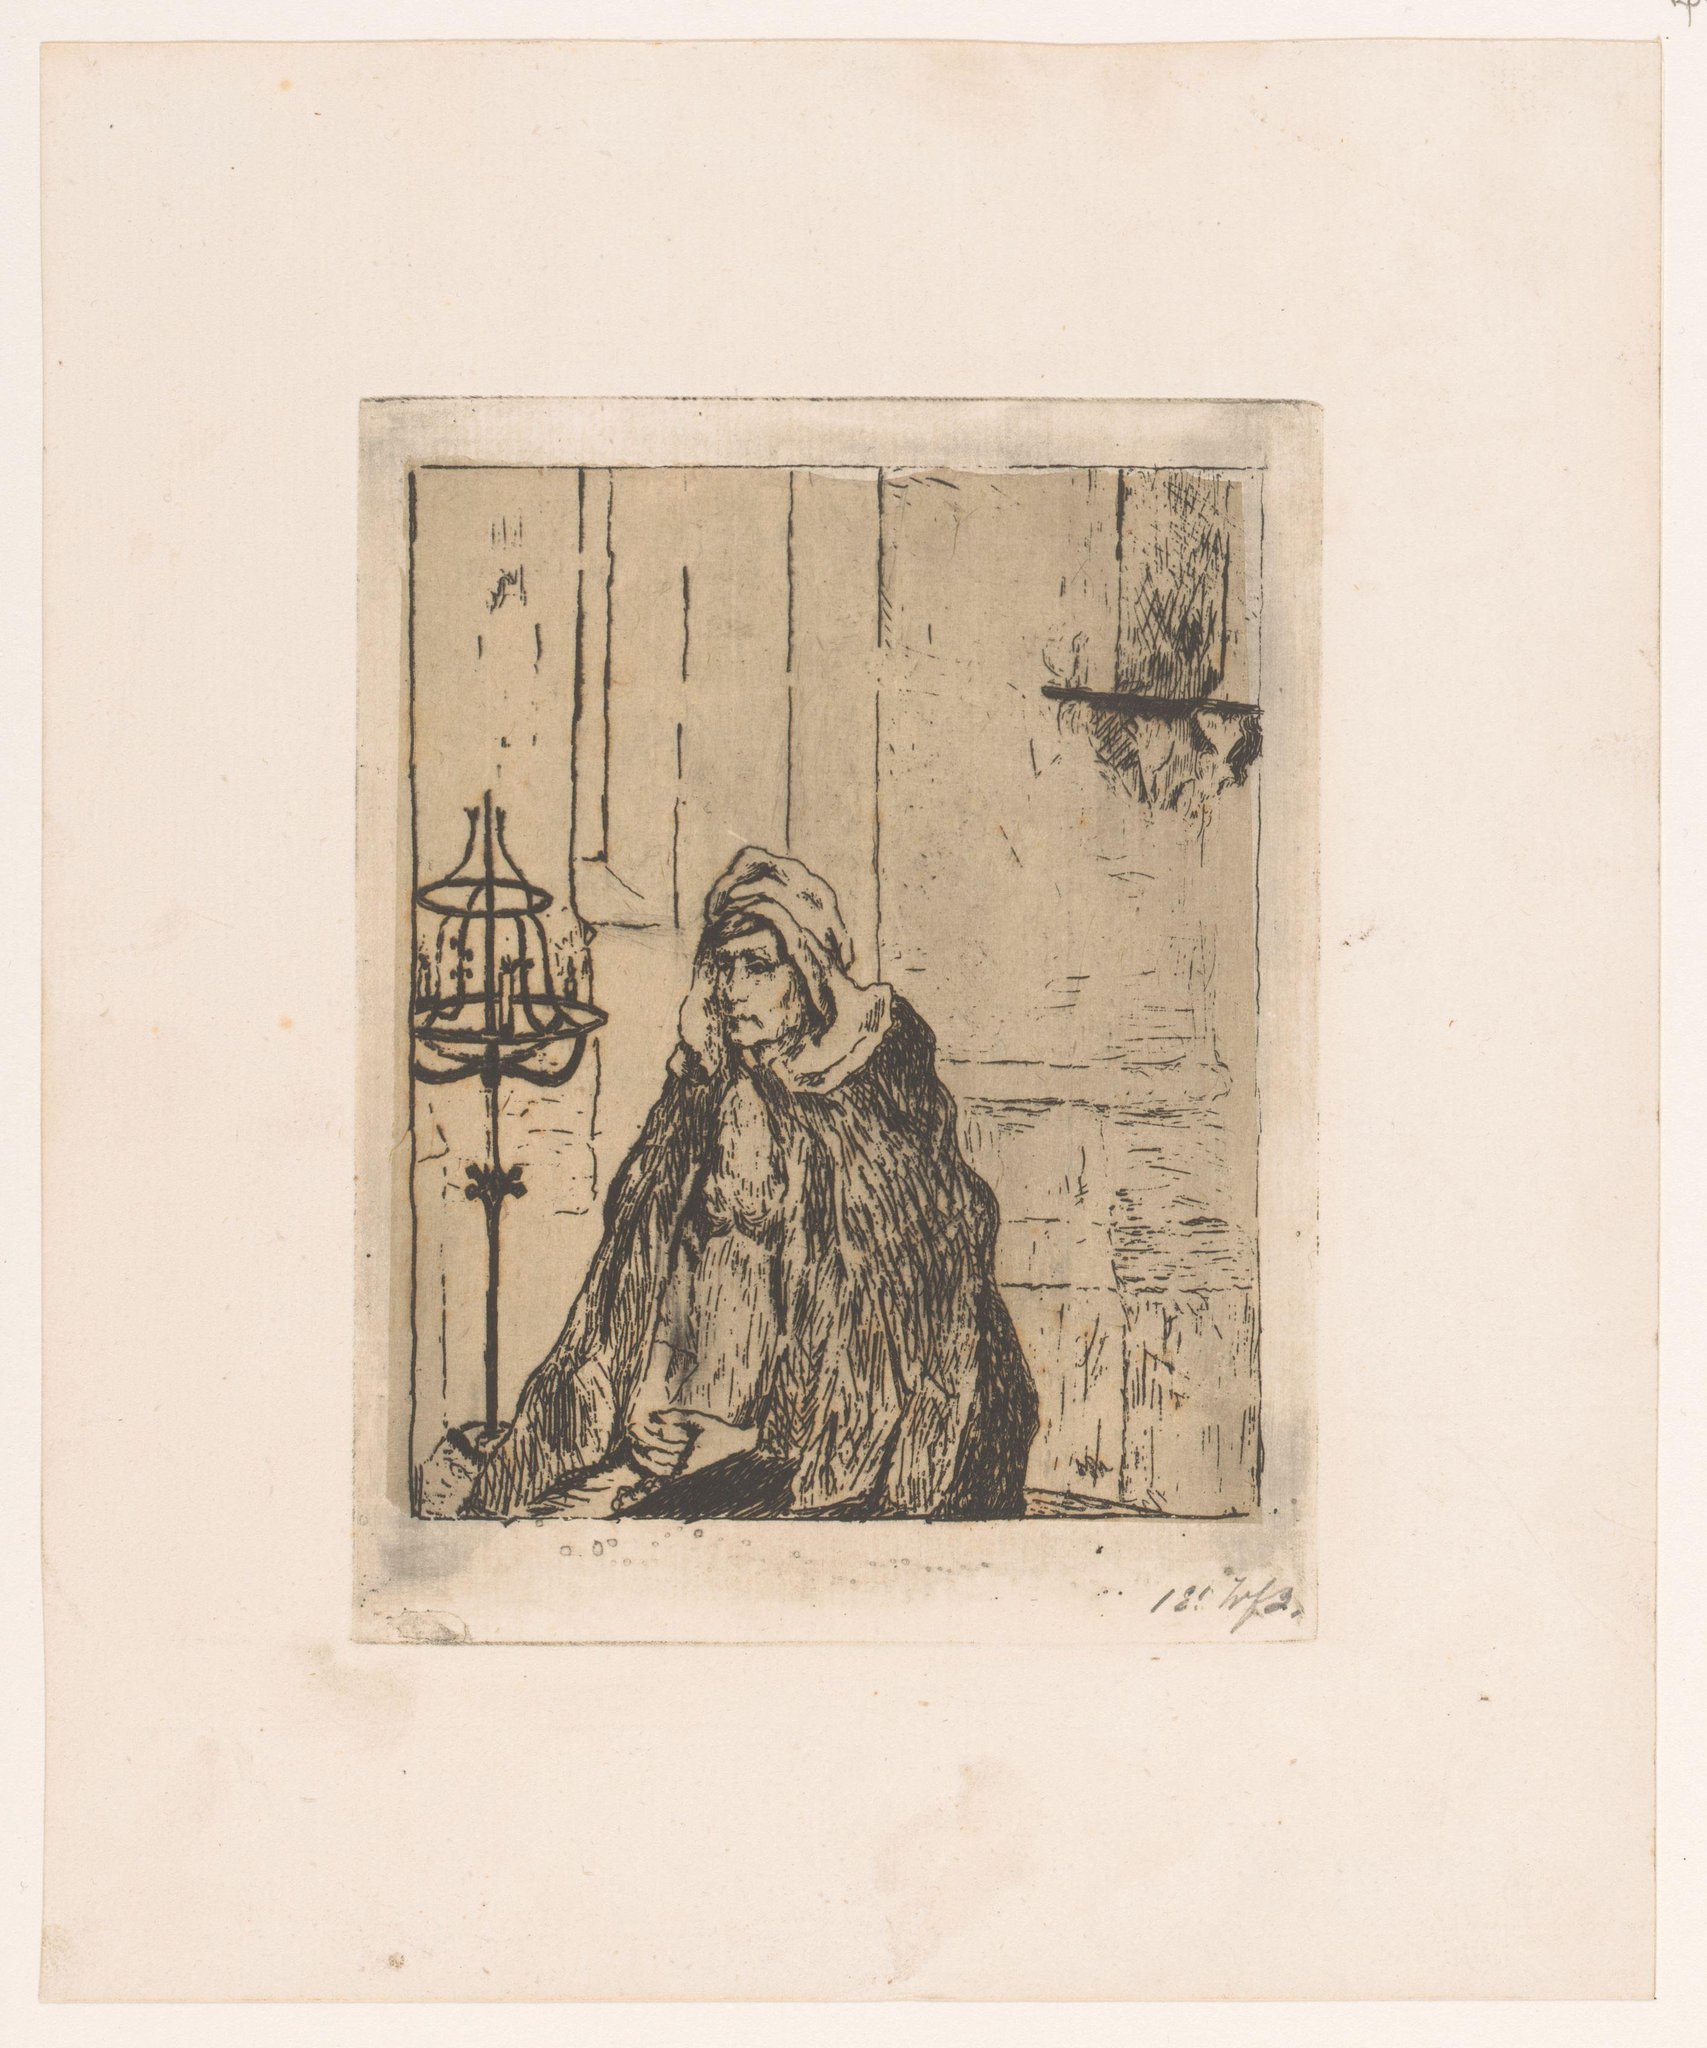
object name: print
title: Biddende dame in kerk of kapel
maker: w.f. barber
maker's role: print maker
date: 1850-1909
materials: paper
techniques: drypoint, etching, intaglio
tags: one person praying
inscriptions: annotation: ‘1 Et. WFB’, collector's mark: Lugt 2228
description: Sterfdatum kunstenaar onbekend. Derhalve is voor bepaling van de rechten van dit object de verwervingsdatum aangehouden.